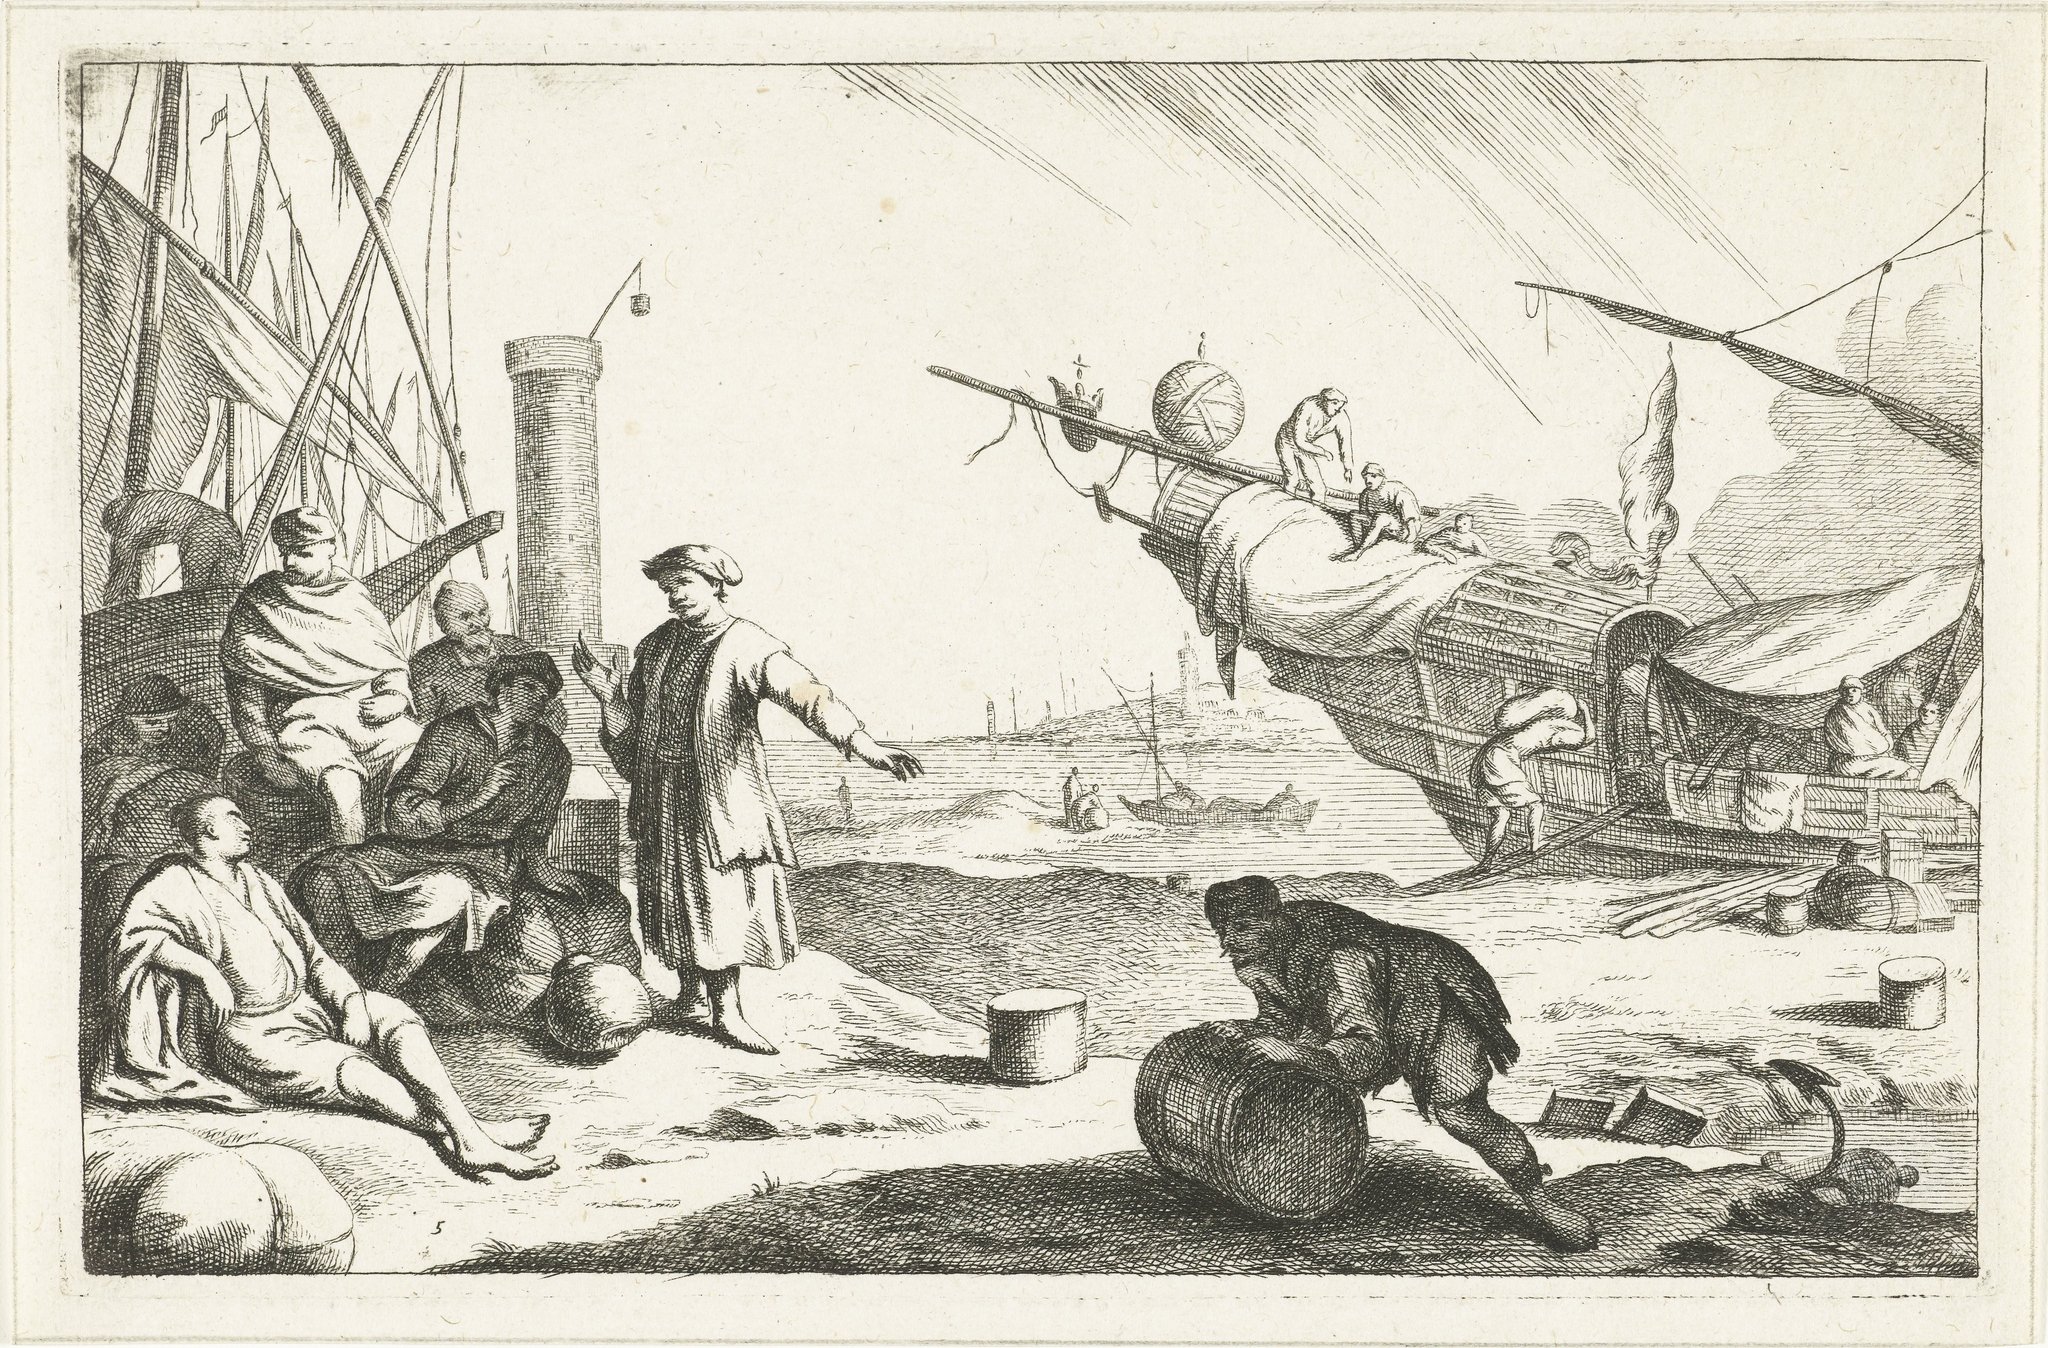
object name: print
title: Aliqui Portus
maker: johannes gronsveld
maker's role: draughtsman, painter, print maker, publisher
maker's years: 1658-1728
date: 1679-1728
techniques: engraving, etching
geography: amsterdam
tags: harbour (+ four persons or more ~ traffic and transport)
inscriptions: collector's mark: ‘b, twee onleesbare letters, l, en een langwerpig figuur’, collector's mark: Lugt 2228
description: Haven met links op de voorgrond een groep buitenlandse kooplieden en rechts een man die een ton verplaatst. Rechts op de achtergrond kooplieden bezig met het inladen van een zeilschip. Vijfde prent uit een serie van twaalf met Italiaanse havens.